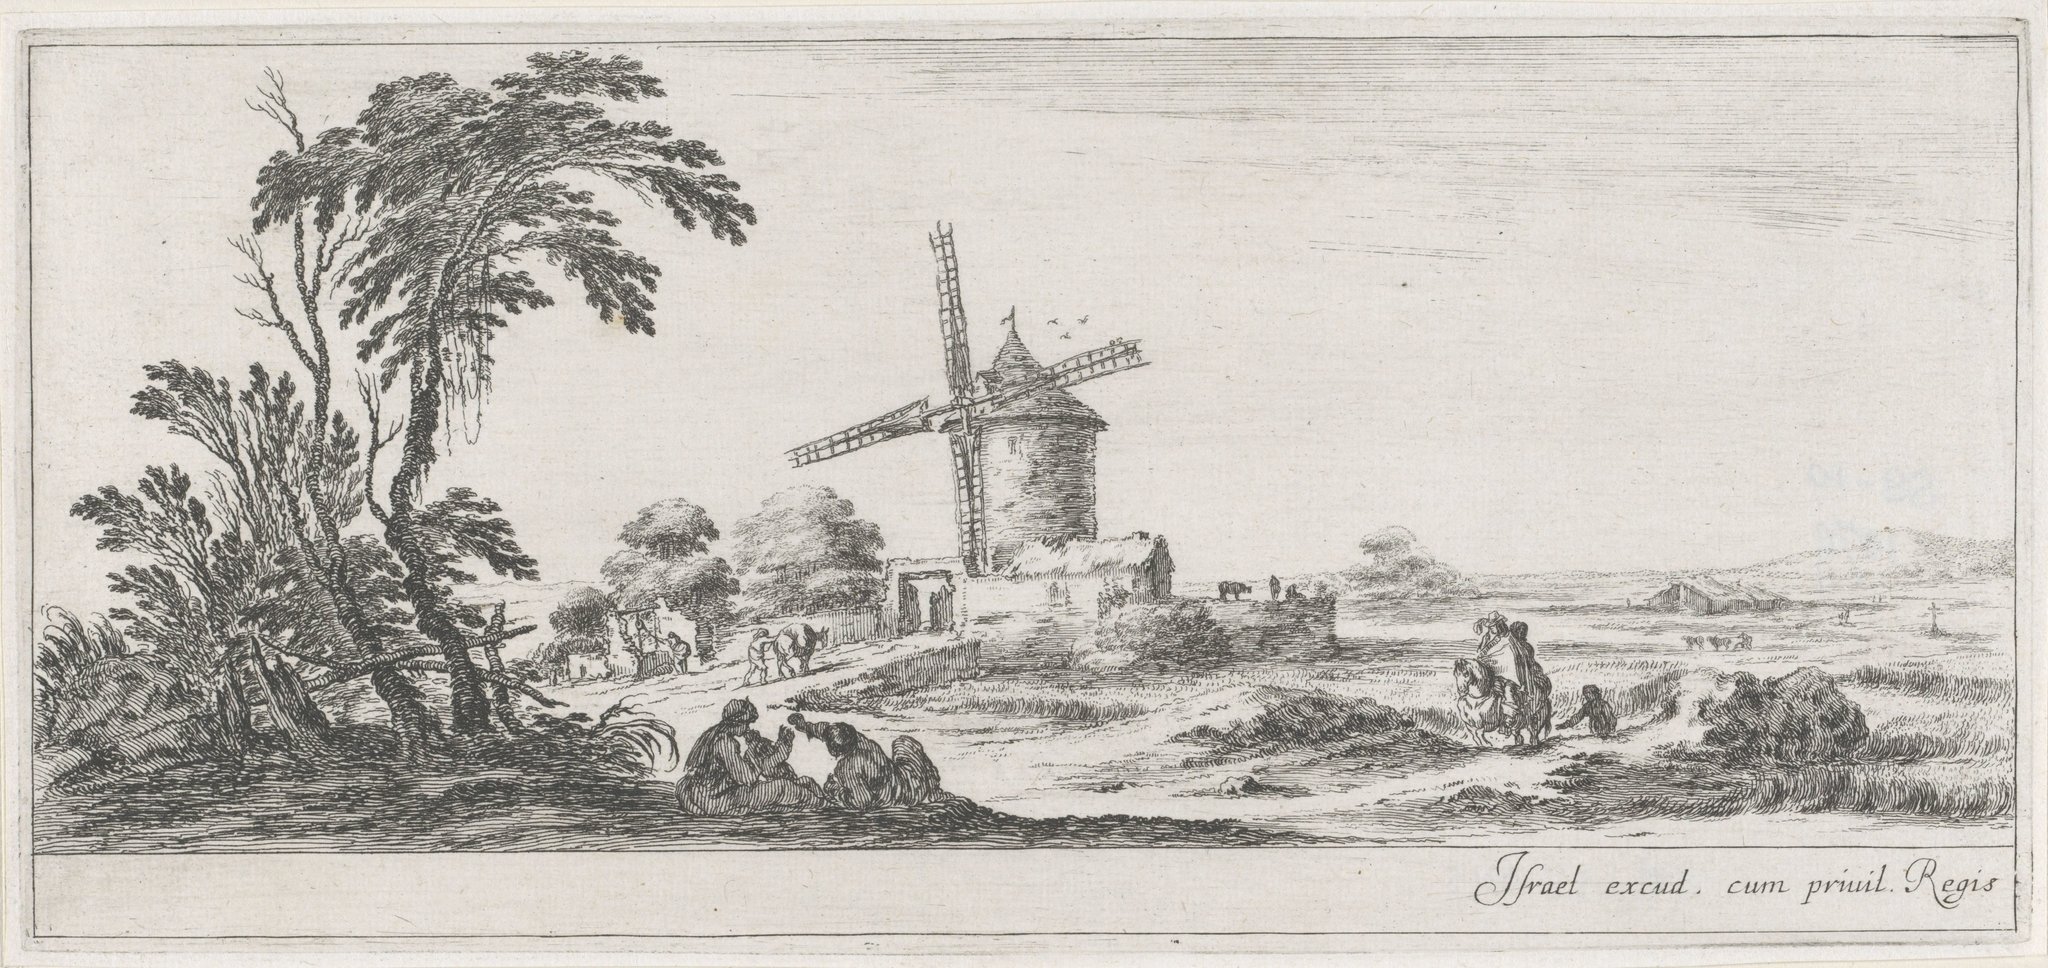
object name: print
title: Diverses paisages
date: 1620-1664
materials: paper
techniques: etching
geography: paris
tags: windmill in landscape - ii - ideal landscapes, landscapes, farmers, windmill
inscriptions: collector's mark: Lugt 240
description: Prent uit een reeks van 12 prenten met landschappen. Getekende voorstudie wordt bewaard in de Hermitage te St. Petersburg (inv. nr. 14177).